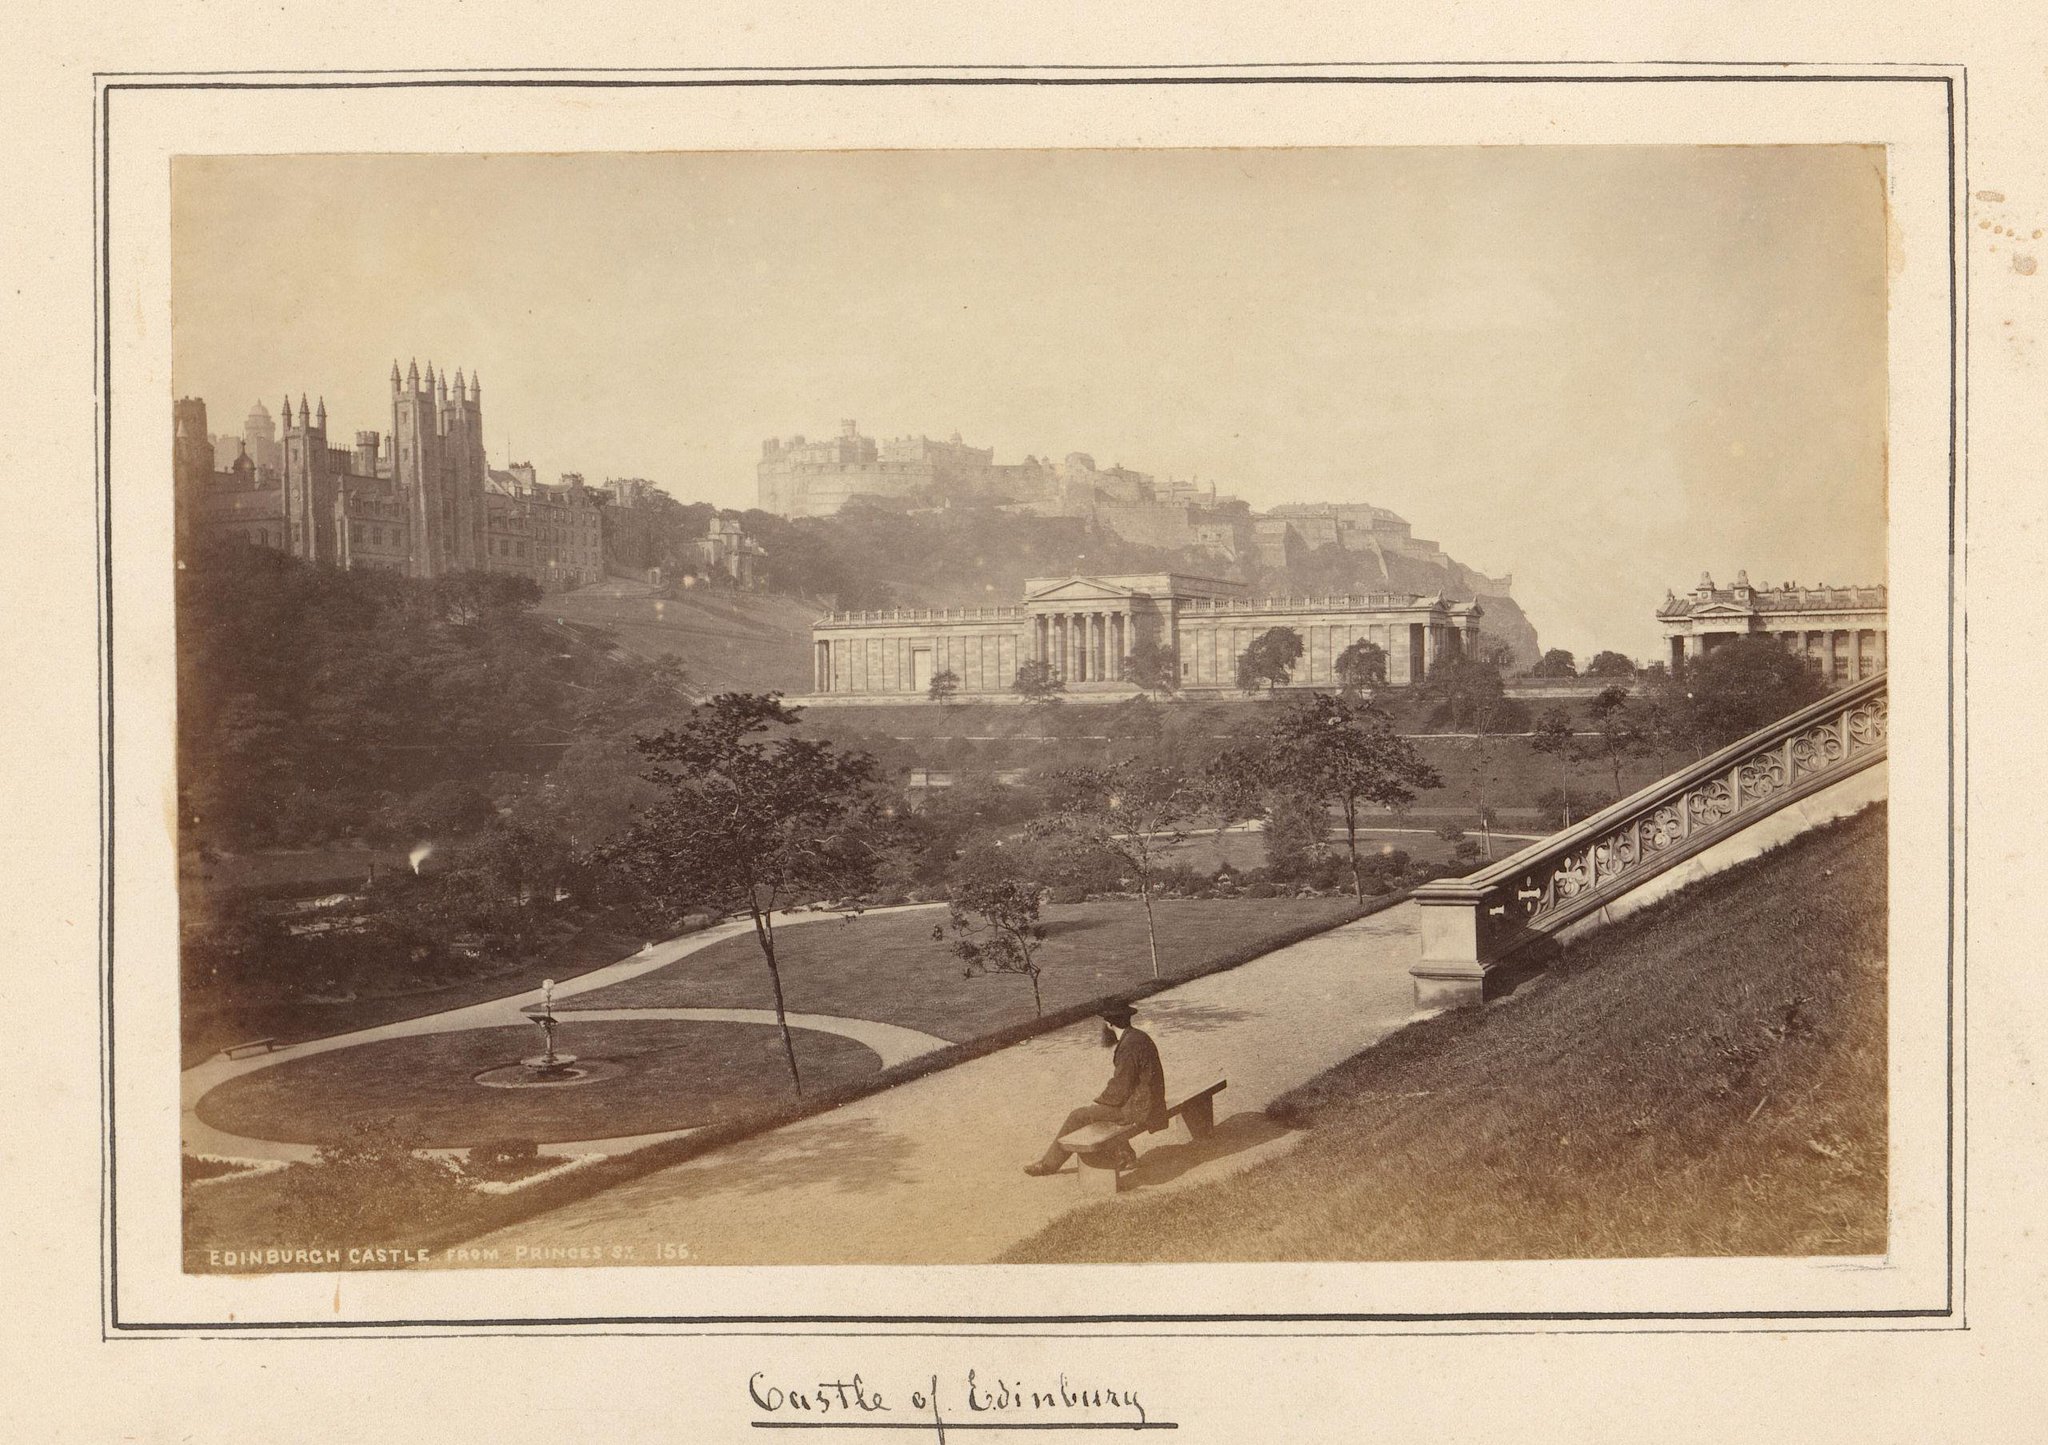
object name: photograph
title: Gezicht op Edinburgh Castle en de National Gallery in Edinburgh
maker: Anonymous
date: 1865-1890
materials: paper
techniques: albumen print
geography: edinburgh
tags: castle, permanent exhibition, museum, public gardens, park, prospect of city, town panorama, silhouette of city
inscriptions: inscription: ‘Edinburgh Castle from Princes St. 156.’